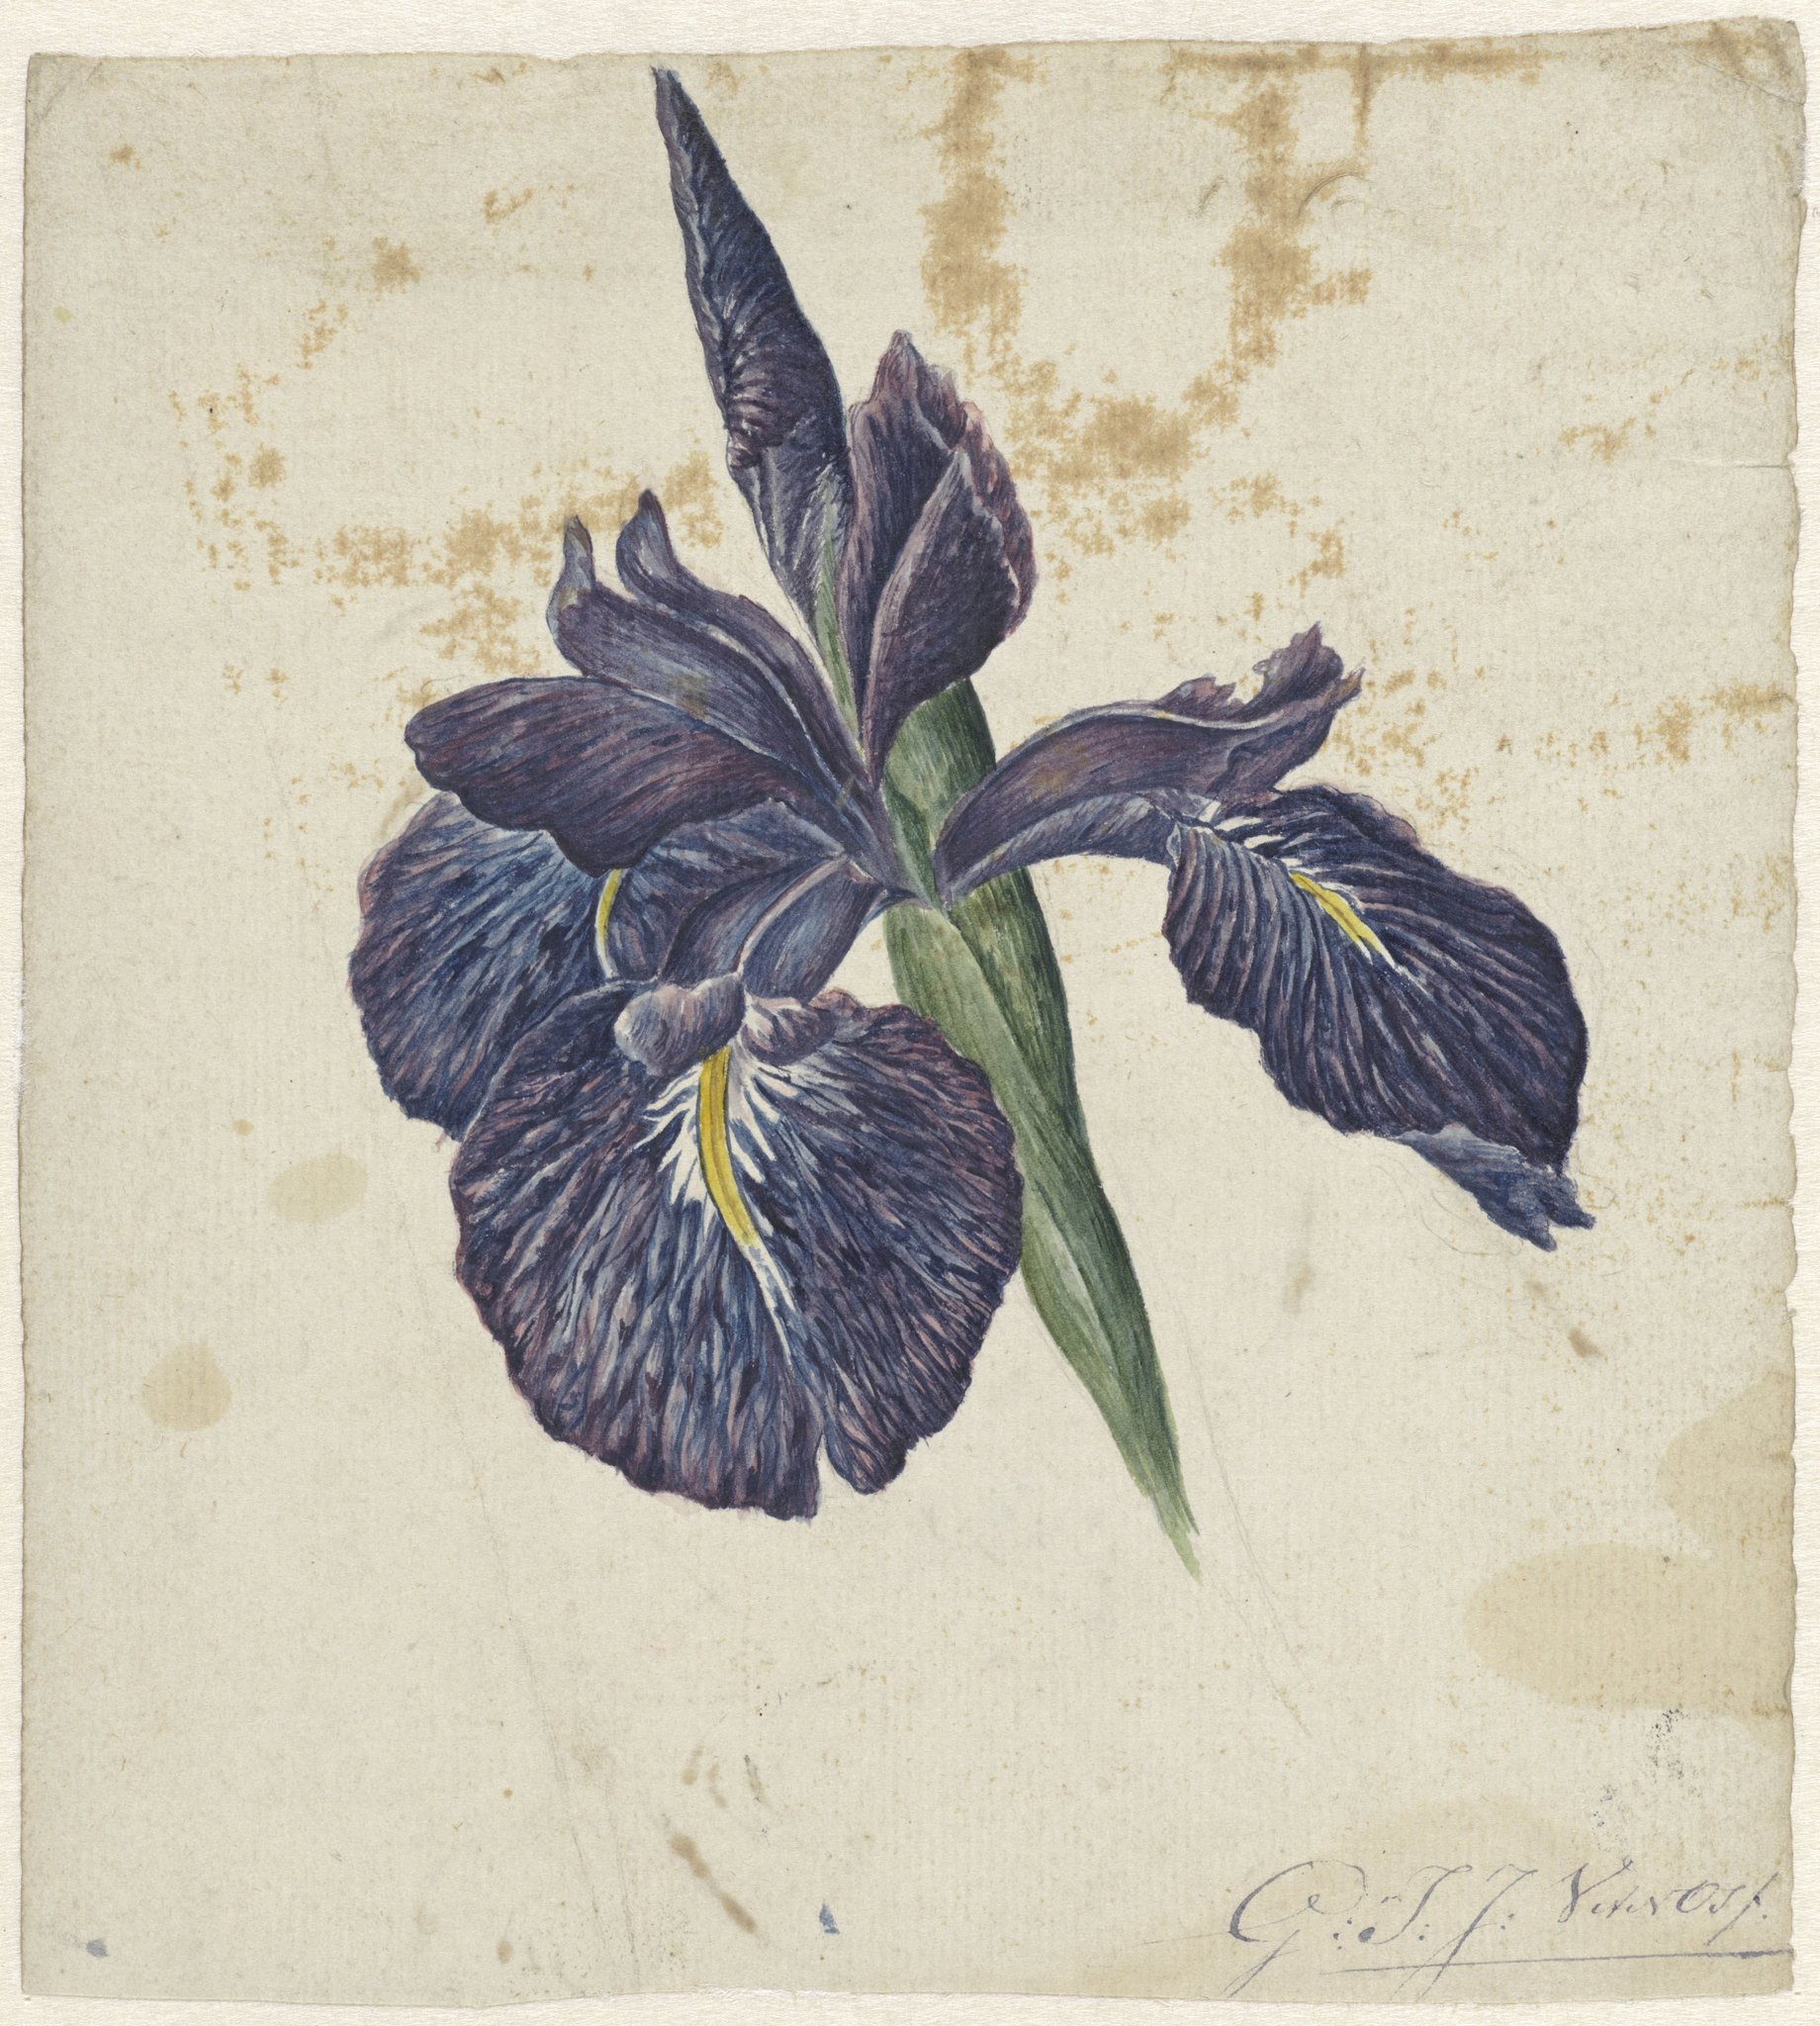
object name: watercolor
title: Iris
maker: georgius jacobus johannes van os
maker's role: draughtsman, painter, print maker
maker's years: 1782-1861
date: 1792-1861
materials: paper, pencil, watercolor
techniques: brush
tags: flowers: iris